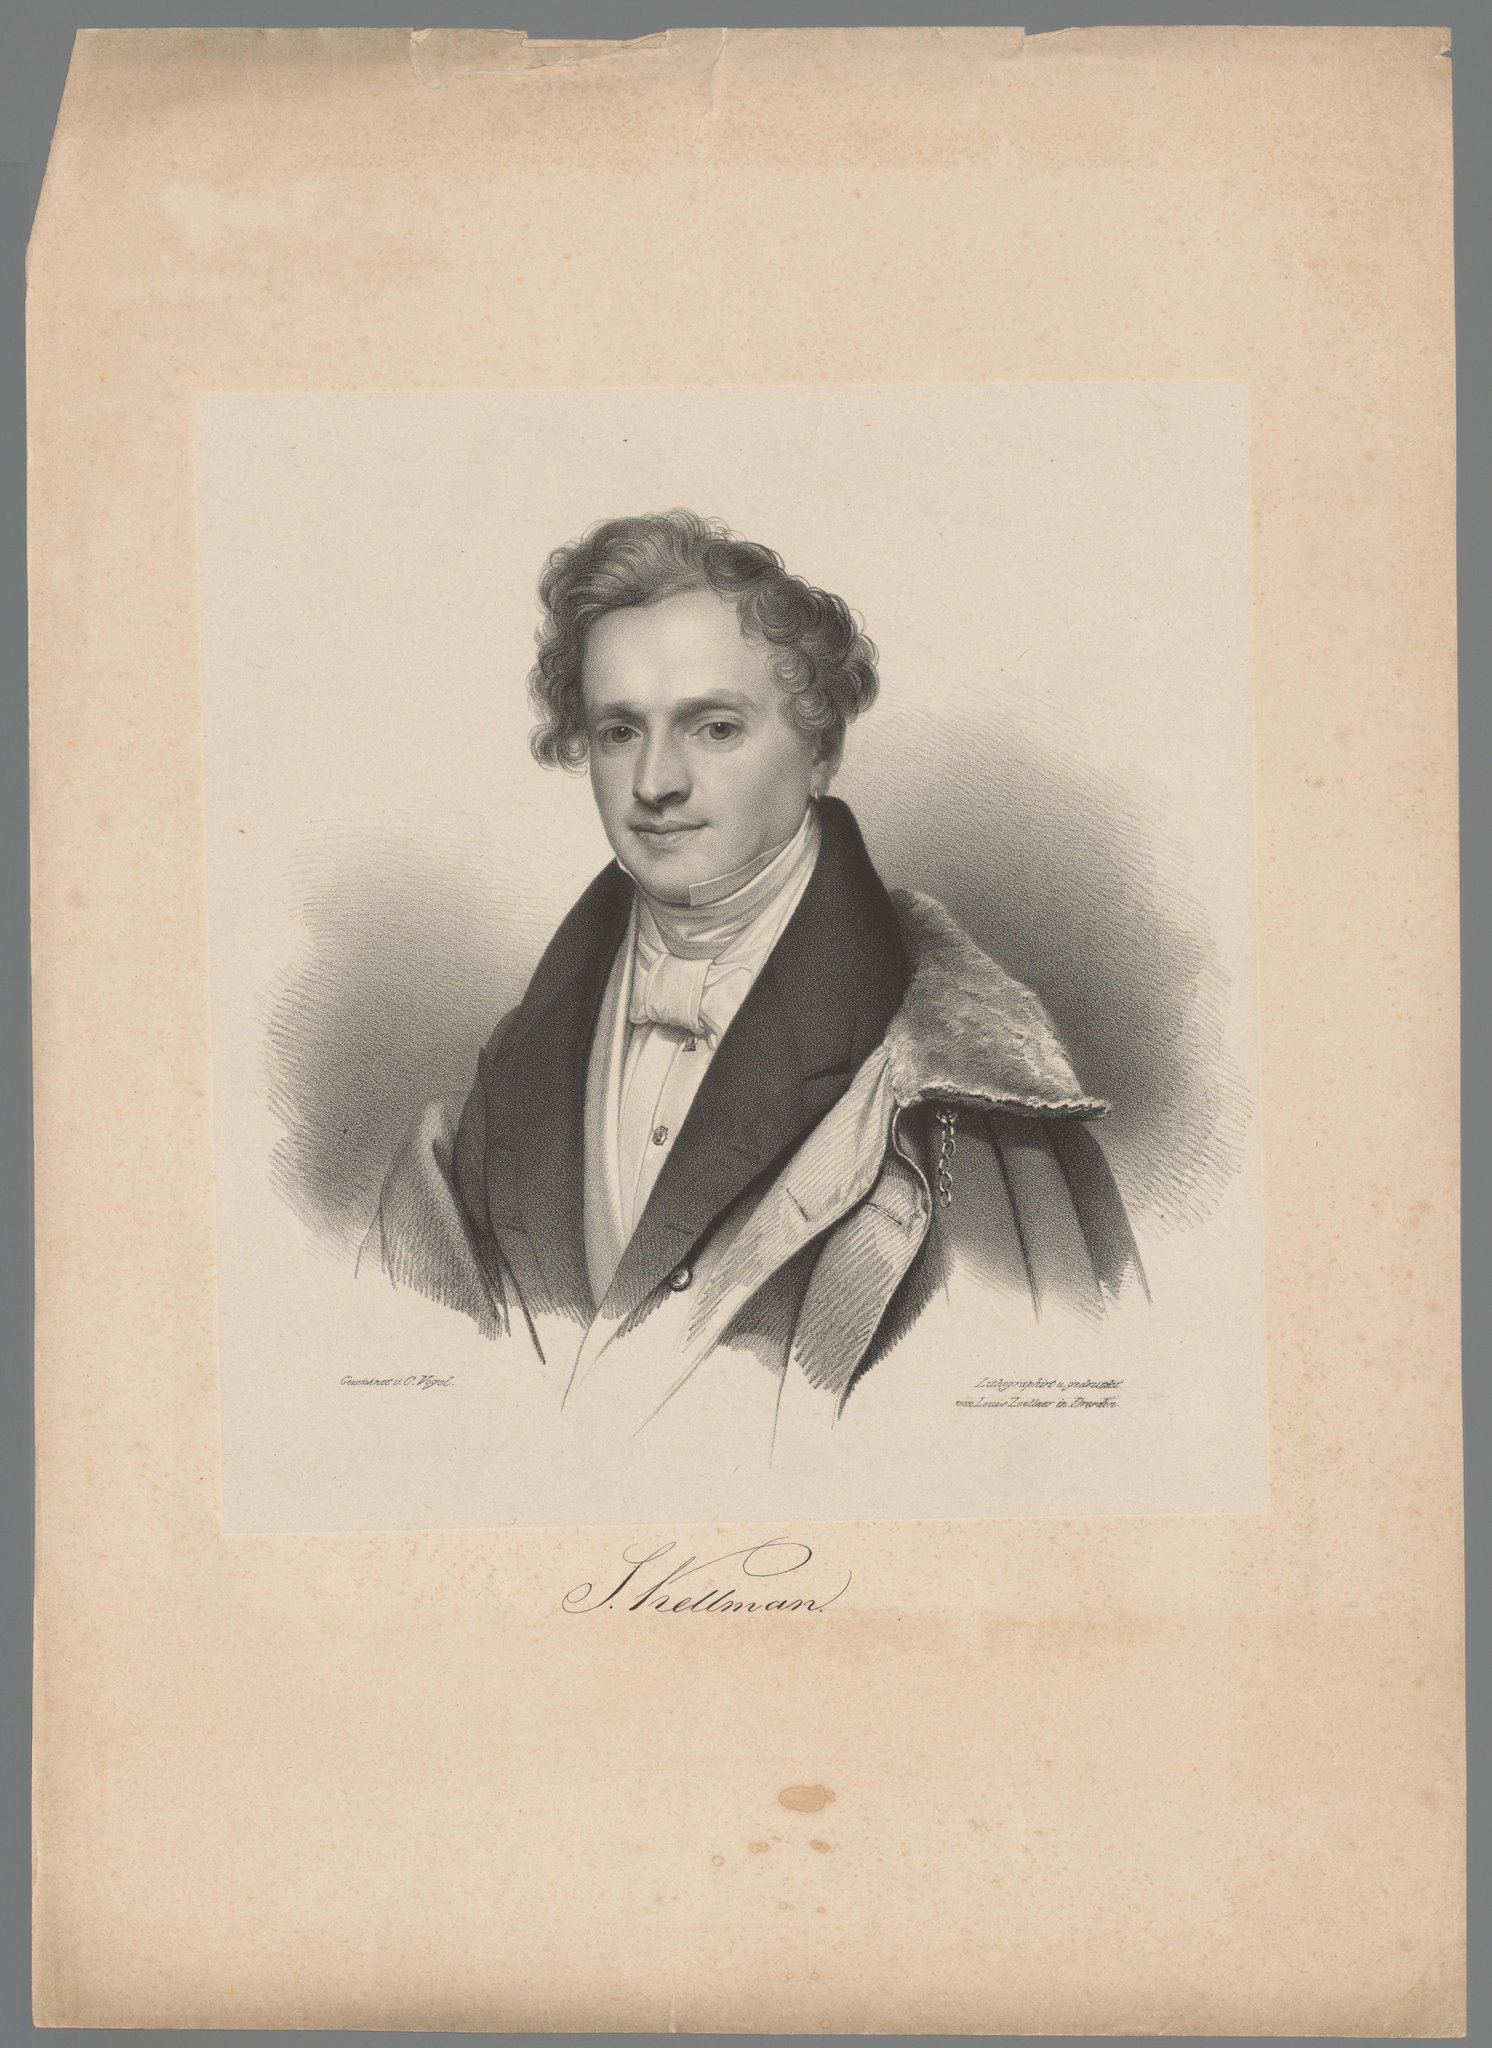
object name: print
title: Portret van een onbekende man, mogelijk S. Kellman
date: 1806-1860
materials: paper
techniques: lithograph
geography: dresden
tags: adult man, historical persons, ear-rings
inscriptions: collector's mark: Lugt 2228